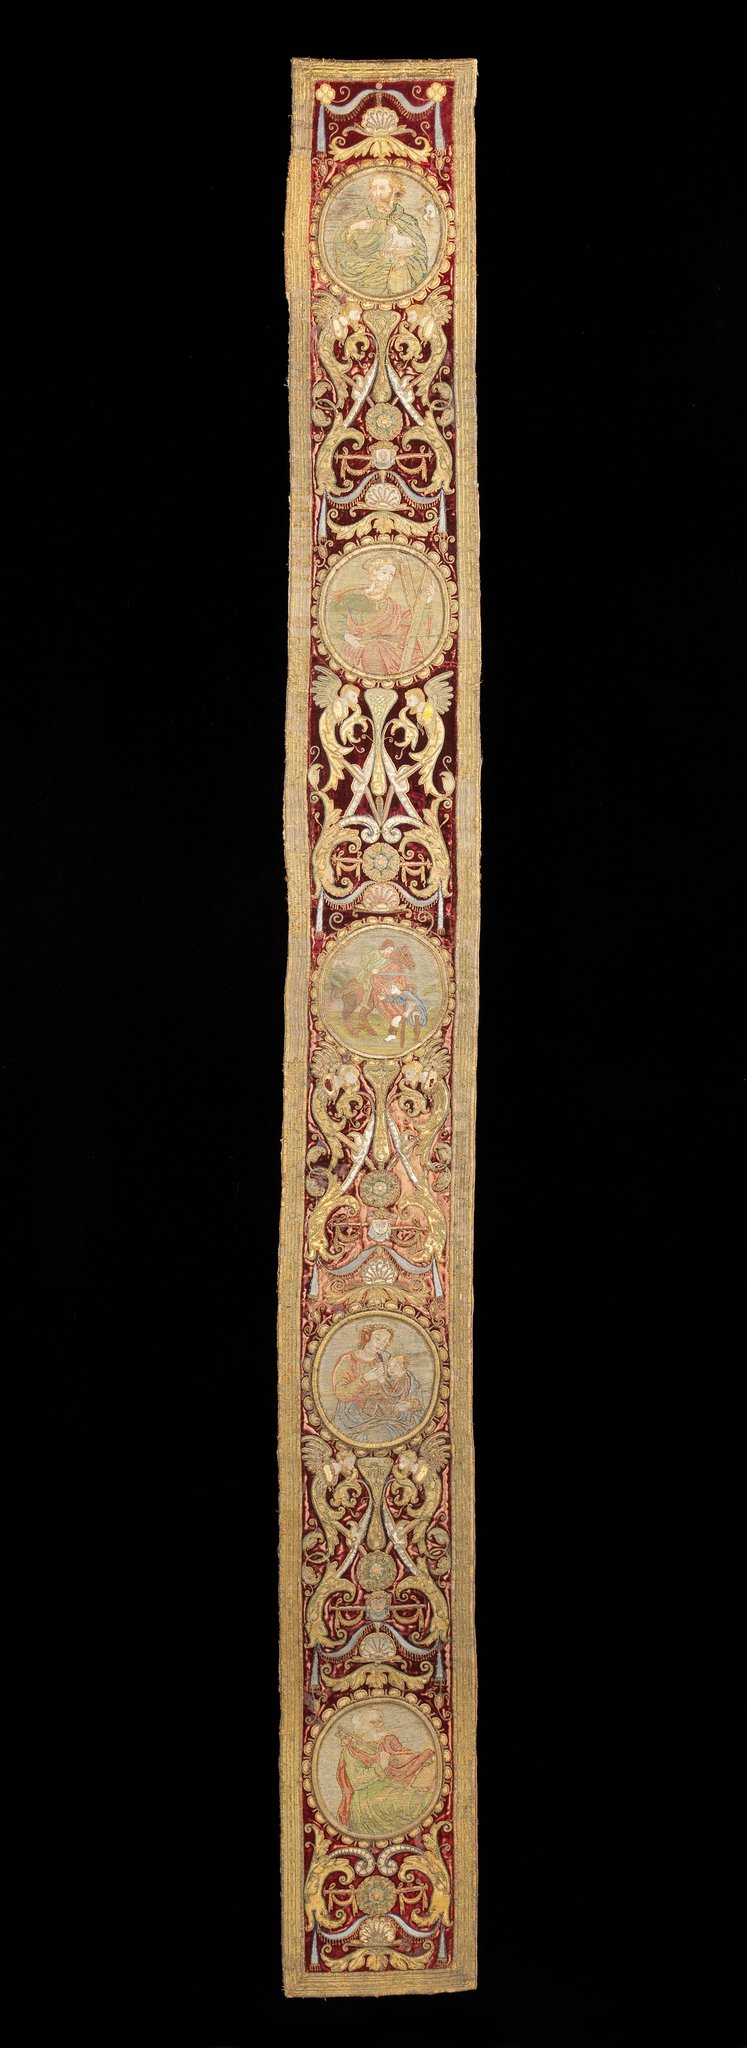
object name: orphrey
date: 1601-1633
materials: metal, silk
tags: men,horses,madonna and child